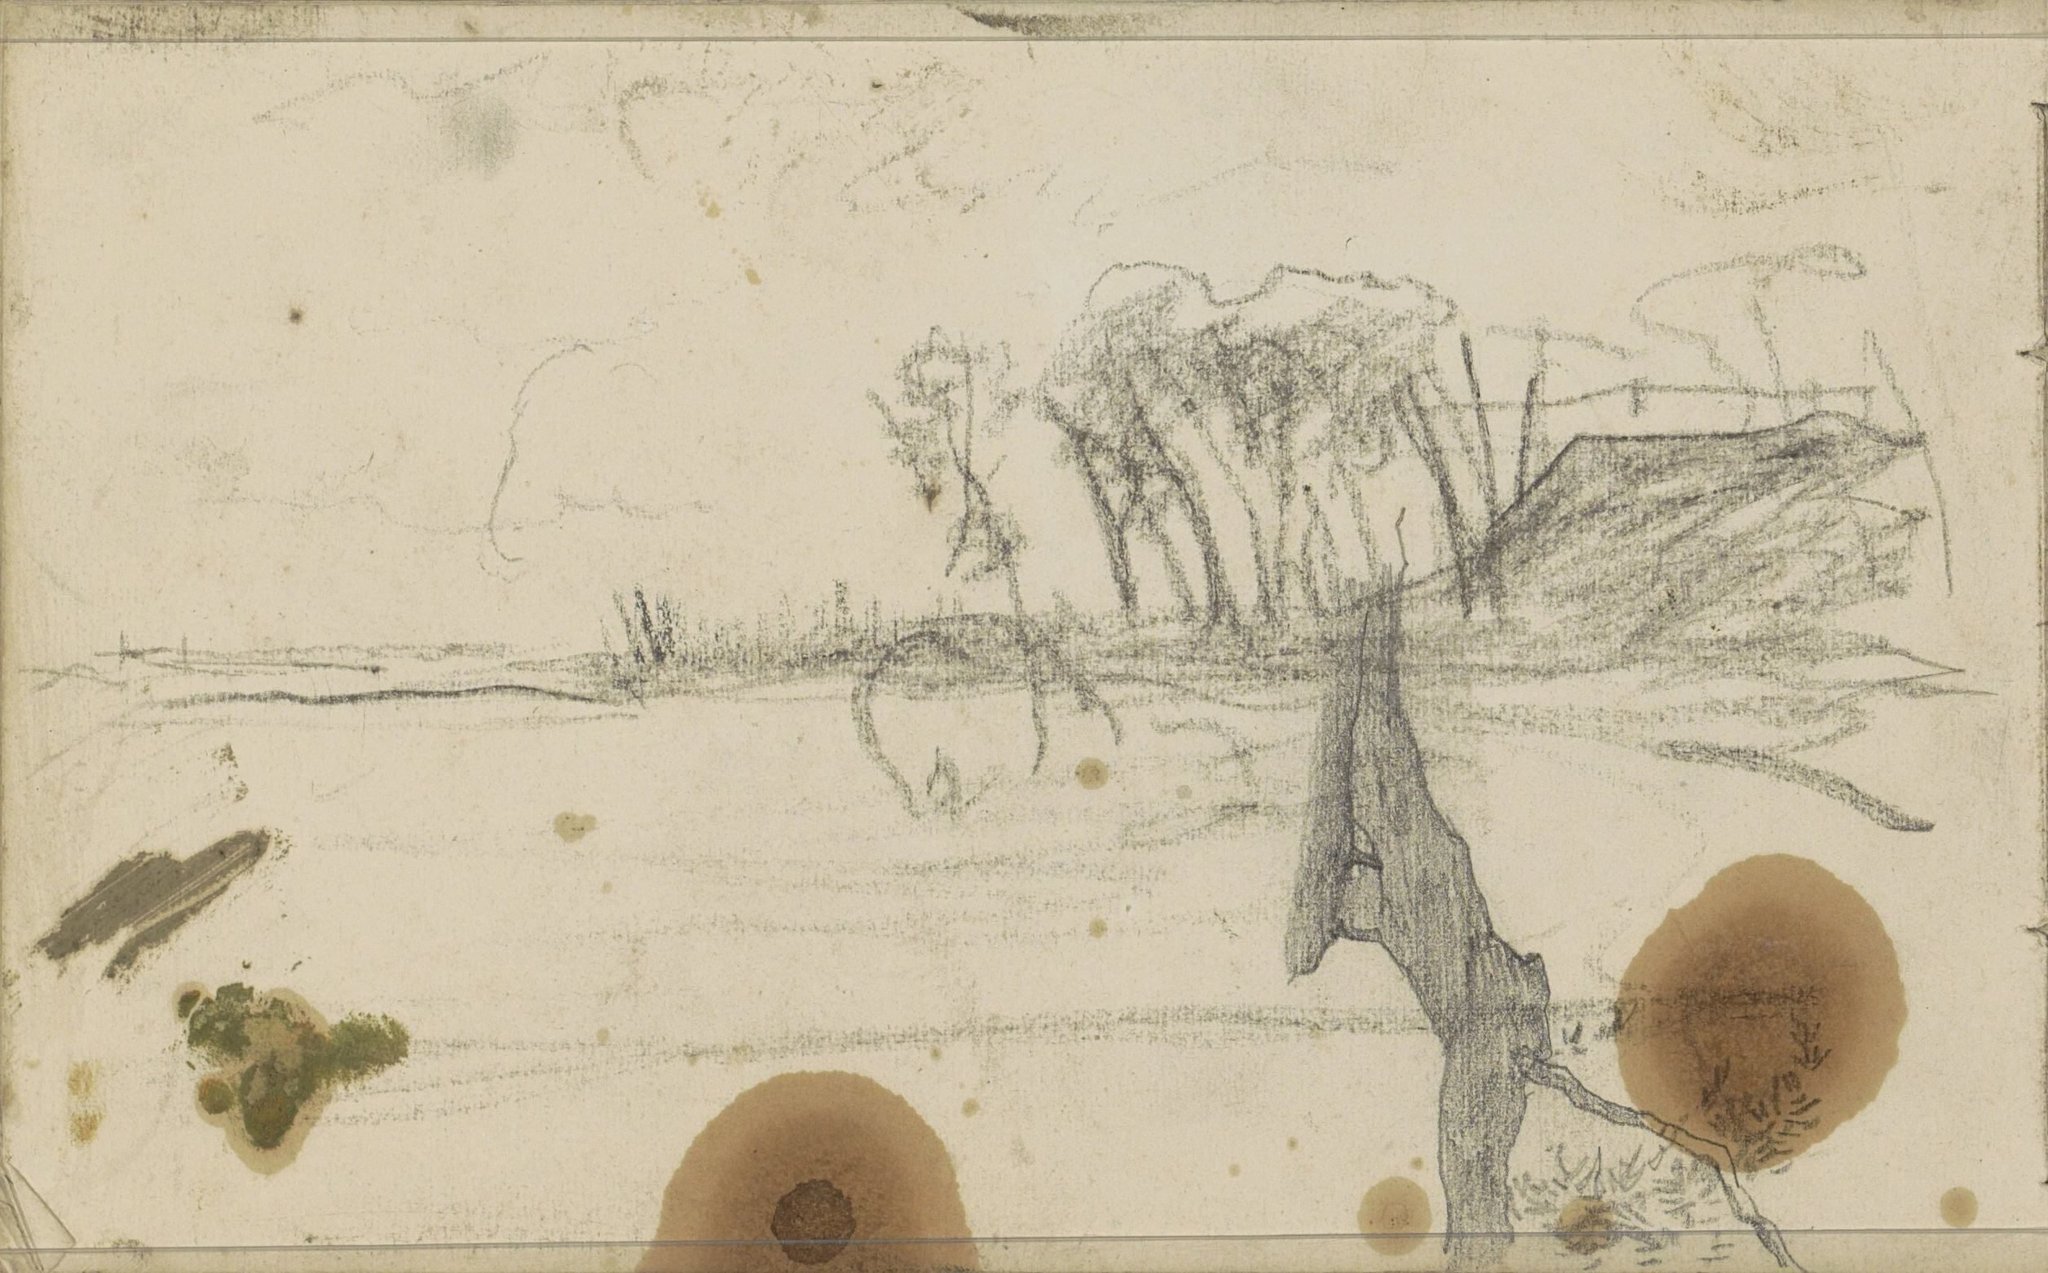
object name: sketchbook leaf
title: Landschap met bomen en een boomstam met takken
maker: anton mauve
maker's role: draughtsman, painter, print maker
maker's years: 1838-1888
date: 1848-1888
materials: chalk, paper, pencil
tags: landscapes, trees (+ stem, trunk)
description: Blad 17 verso uit een schetsboek met 42 bladen.